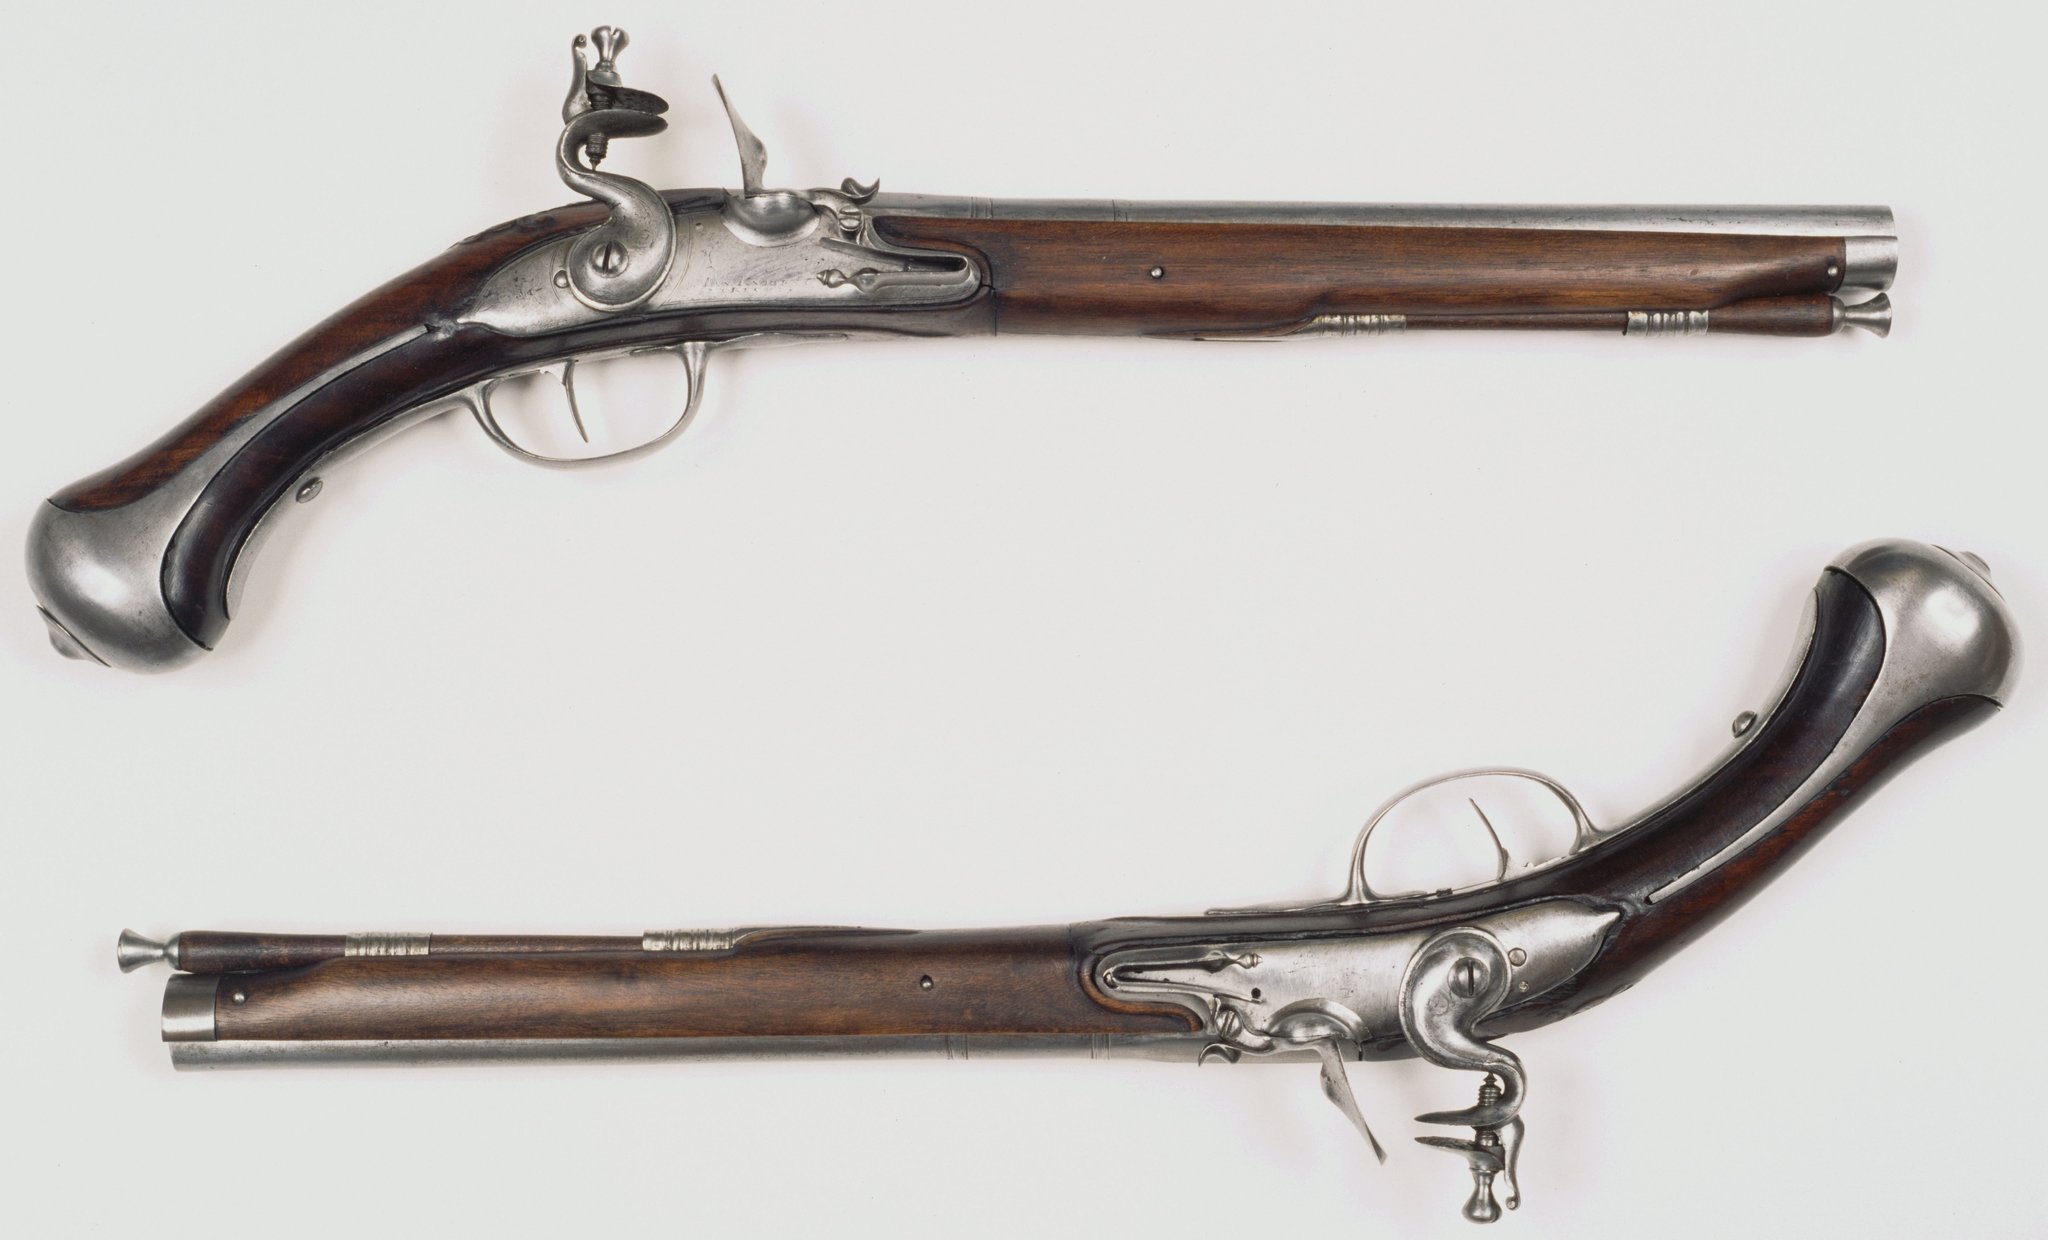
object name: flintlock pistol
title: Vuursteenpistool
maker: jan knoop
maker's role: geweermaker, lademaker, pistoolmaker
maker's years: 1610-1688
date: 1619-1688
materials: iron, wood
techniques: embroidery, engraving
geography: utrecht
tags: netherlands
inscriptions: mark: ‘IAN KNOOP // UTRECHT’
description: Vuursteenpistool, onderdeel van koppel, met ijzeren ronde gladde loop onderbroken door twee profielbanden waarna de loop achthoekig doorloopt. De slotplaat is van ijzer waar onder de pan de naam "IAN KNOOP" staat gegraveerd met daaronder "UTRECHT". De kolf is van notenhout en heeft een ijzeren kolfkap met op de kop een ijzeren plaat met in het midden een uitstulping. Op de kolfhals een uitgesneden bloemmotief. Aan de andere zijde van de lade een ijzeren beslag in de vorm van bloemmotieven. De trekkersbeugel is geheel van ijzer. Onder de lade een houten laadstok in een koker welke de uiteinde van ijzer is. De kop van de laadstok is van ijzer.